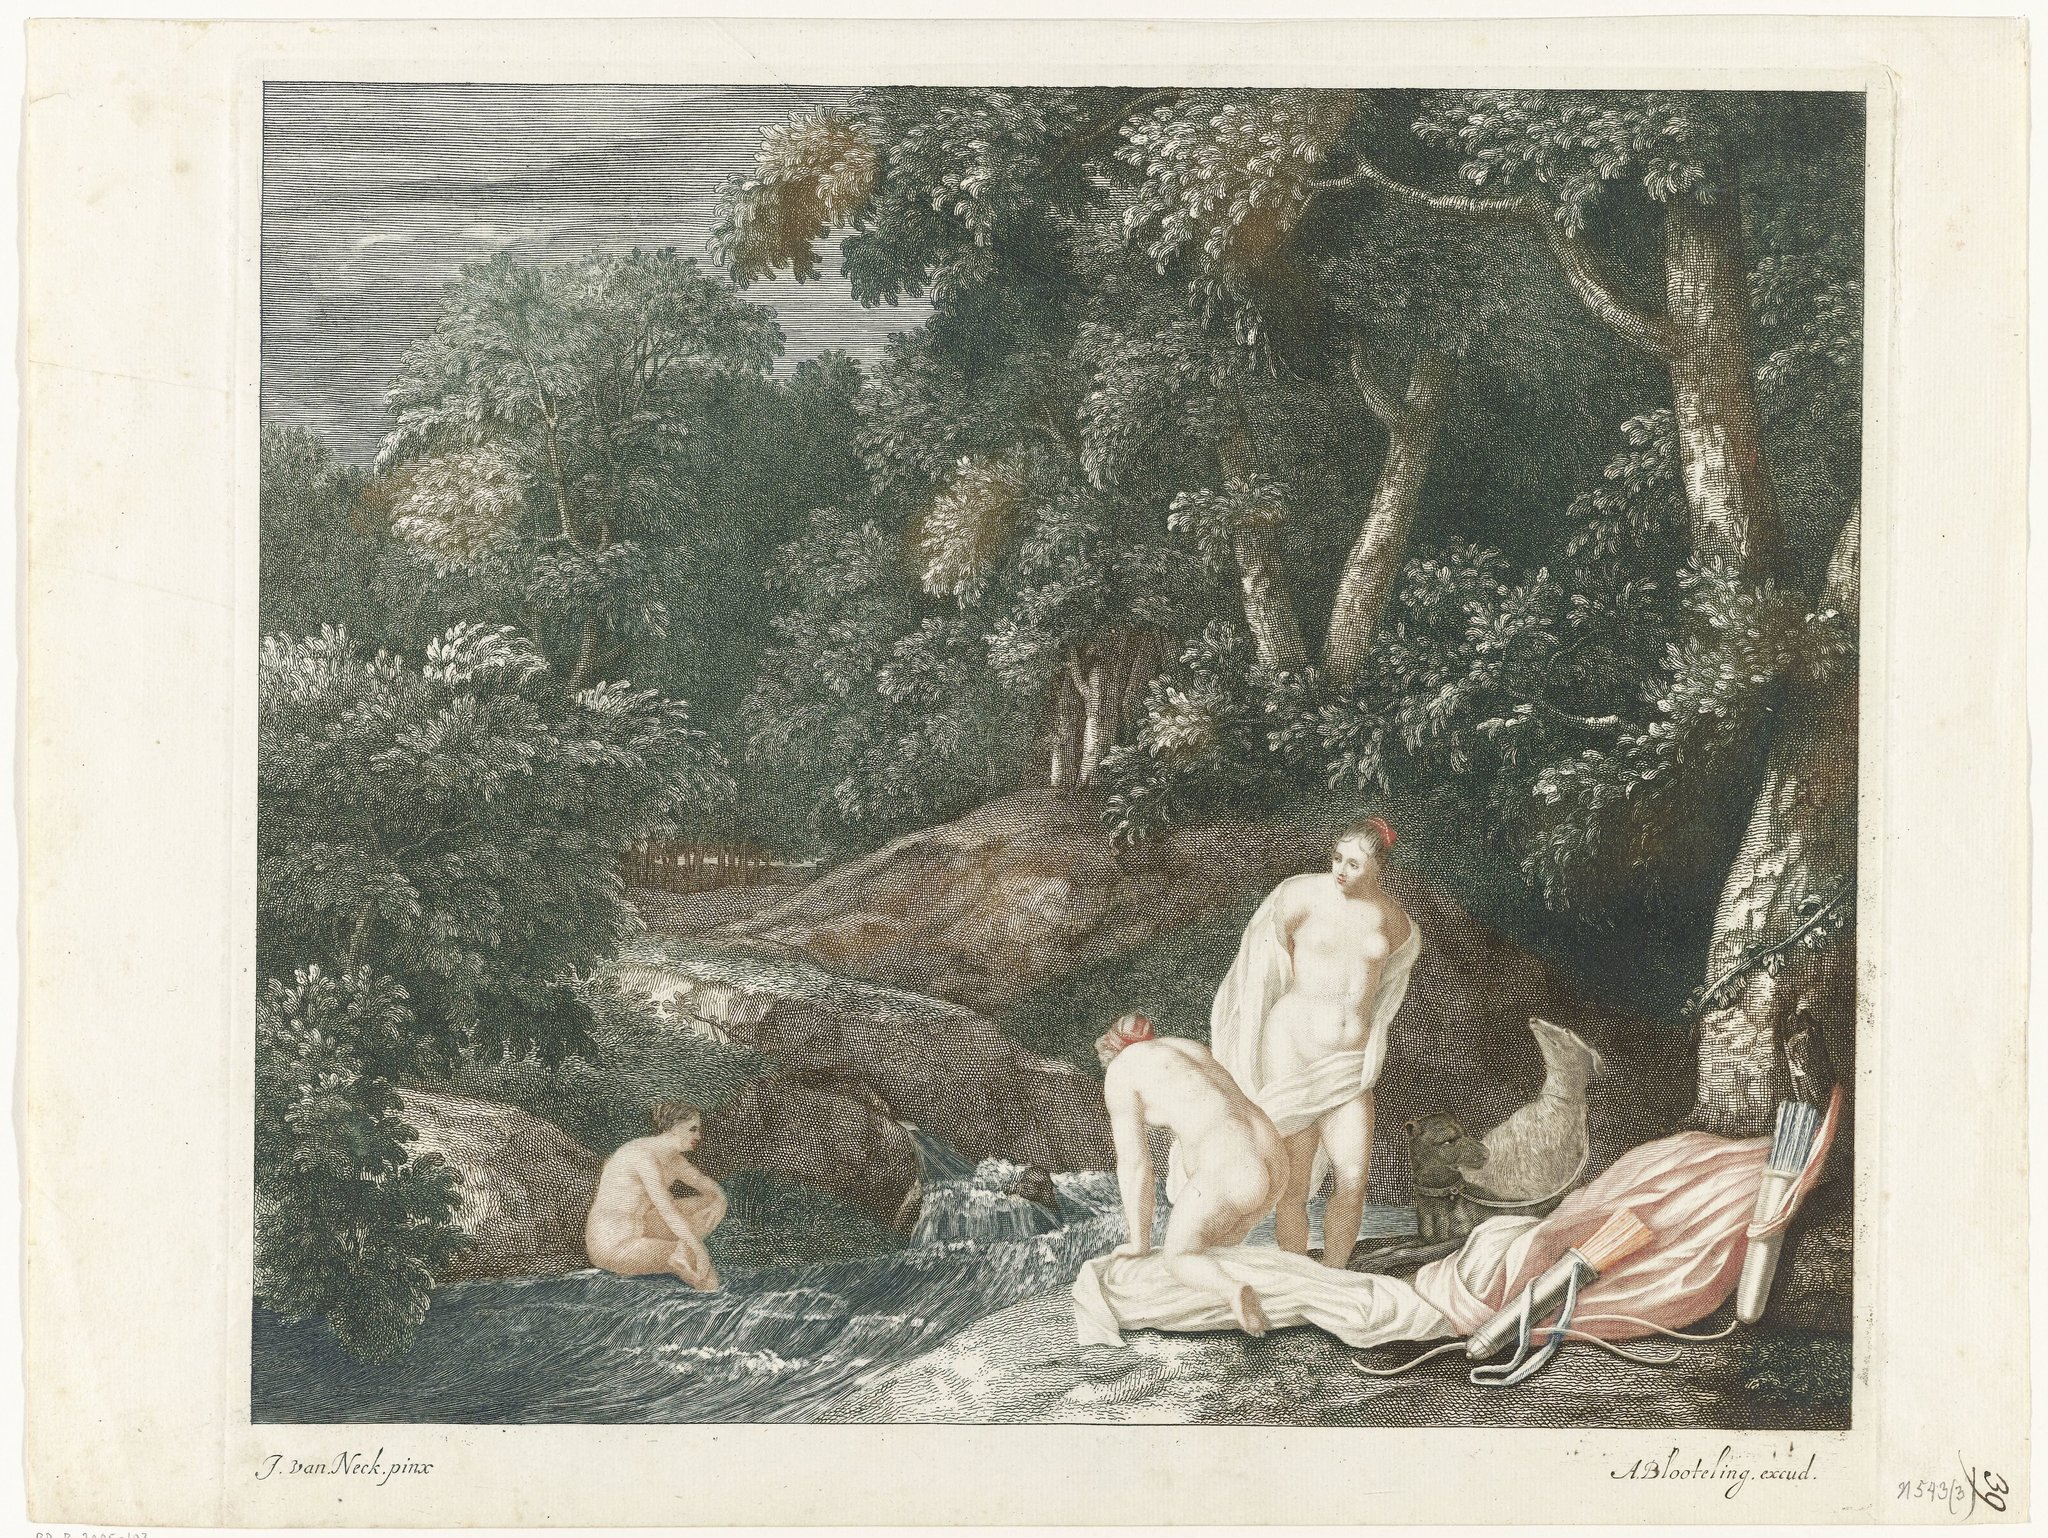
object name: print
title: Diana en haar nimfen, badend in een rivier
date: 1655-1690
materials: paper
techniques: etching, lithography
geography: amsterdam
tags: diana bathing with her nymphs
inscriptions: collector's mark: Lugt 2228, collector's mark: Lugt 2760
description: Een drietal nimfen neemt een bad in een bosbeek. Aan de oever liggen hun kleding, pijlenkokers en twee honden.